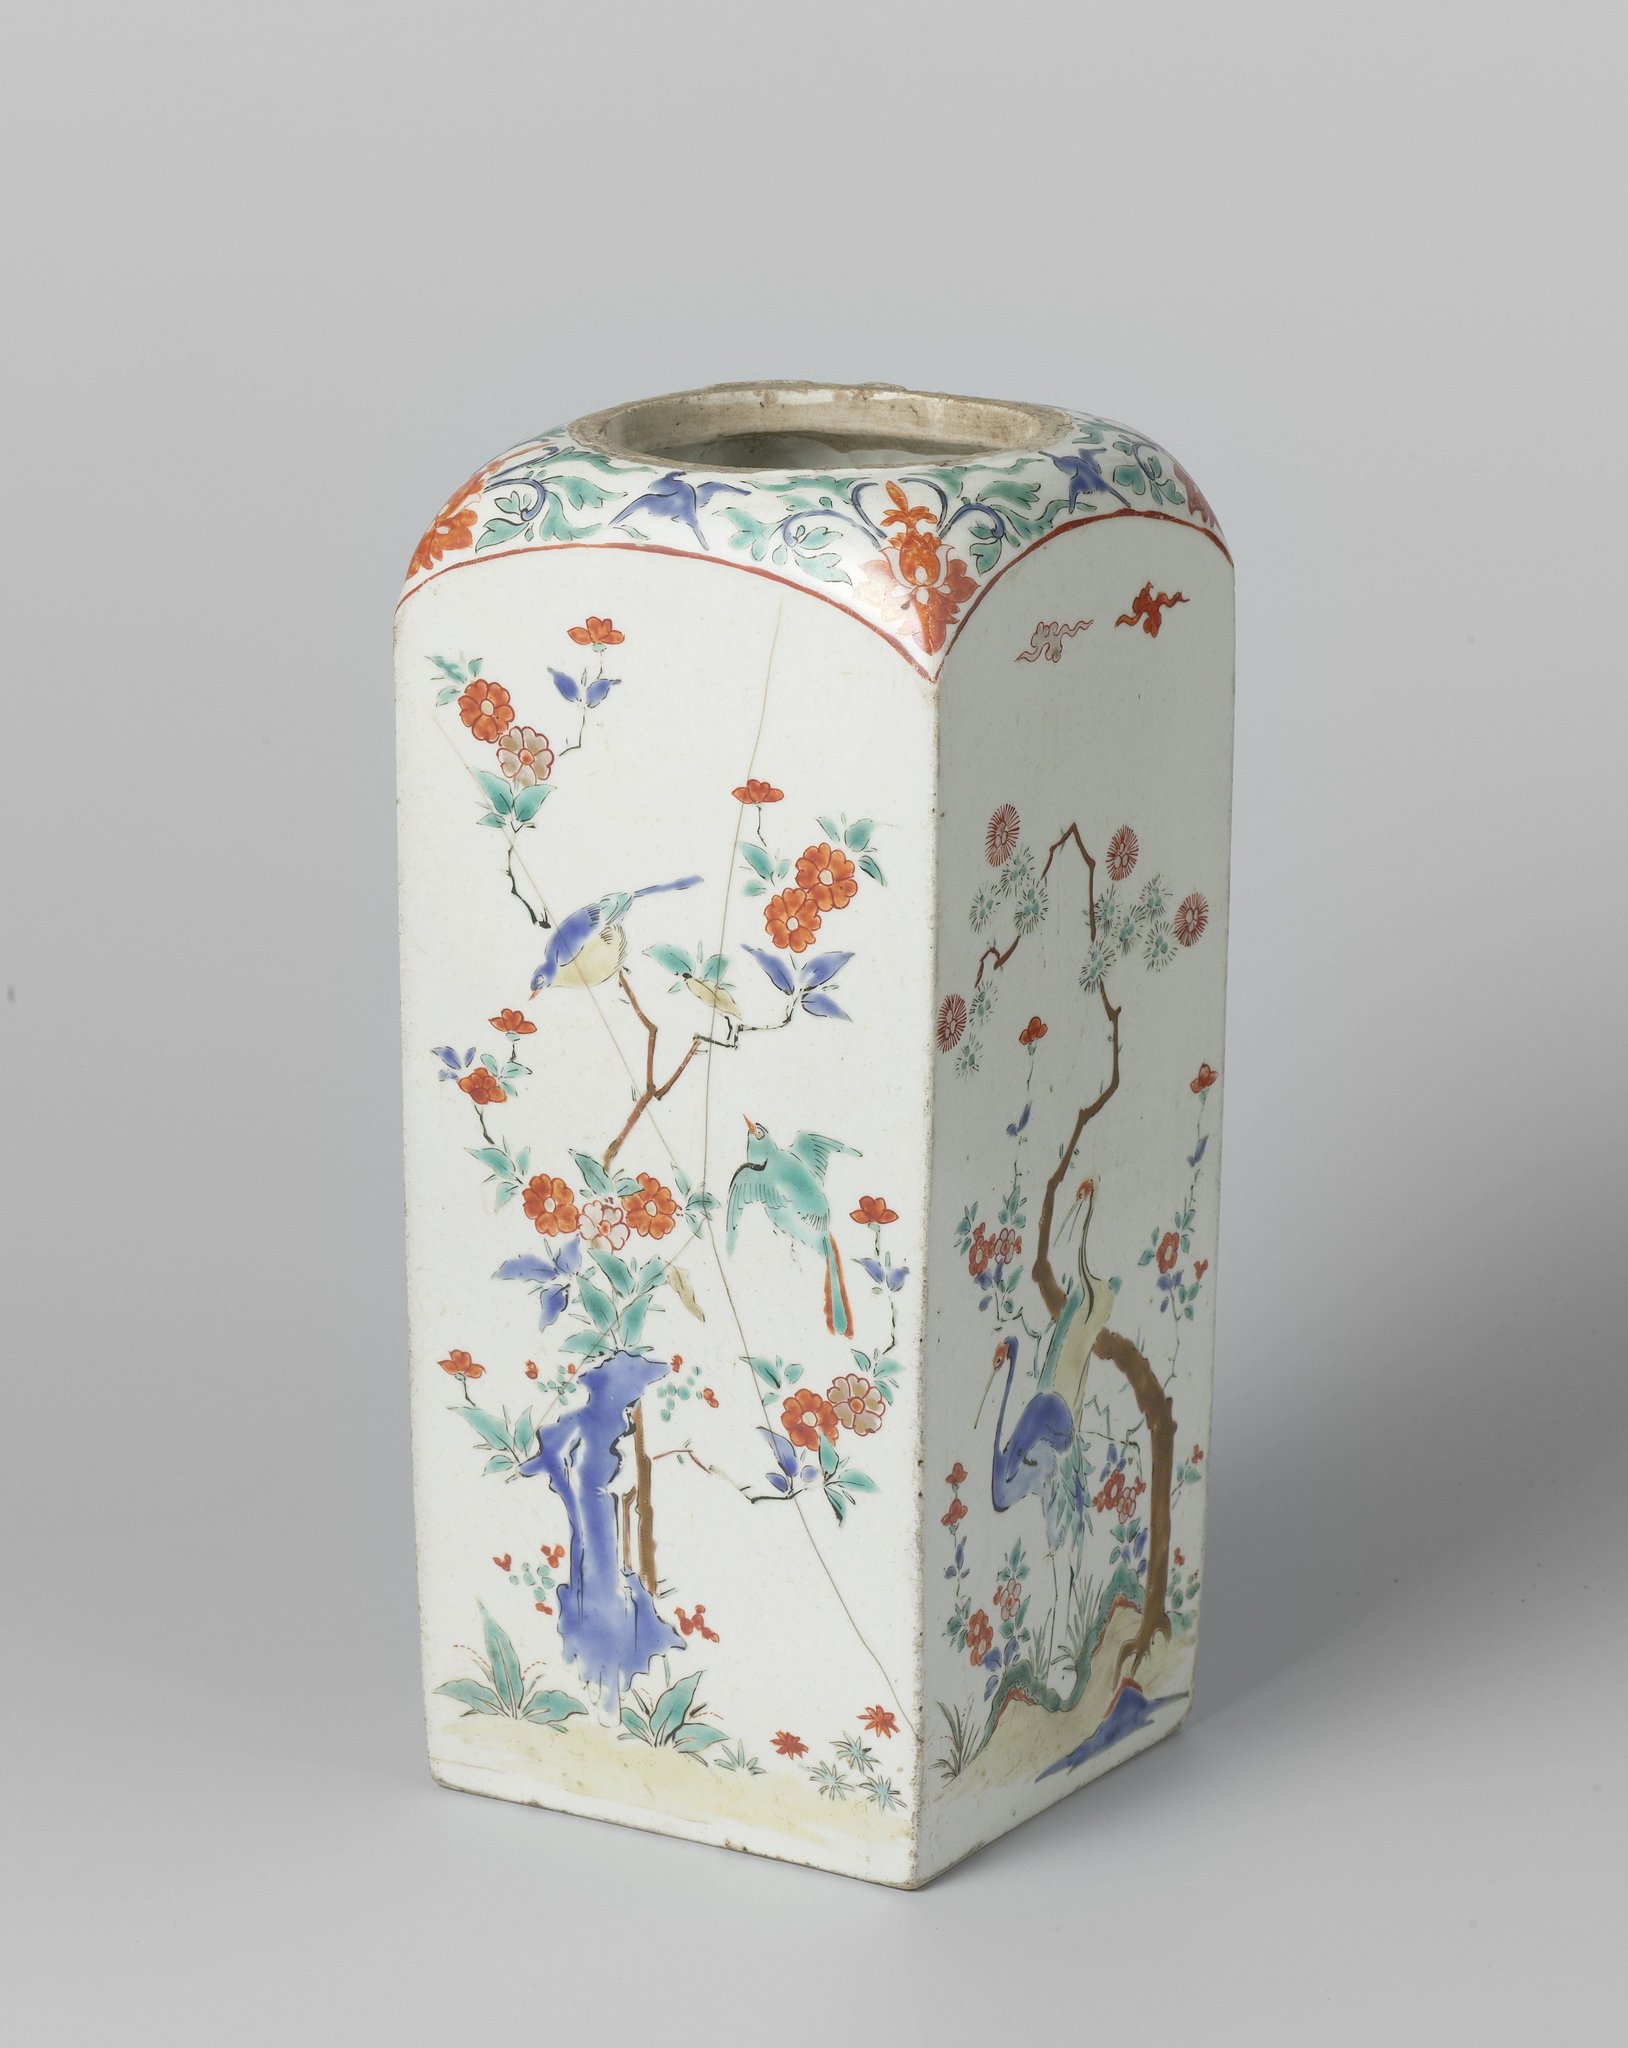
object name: bottle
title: Square bottle with the 'three friends', birds and floral scrolls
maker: Anonymous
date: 1670-1690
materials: glaze, gold, paint, porcelain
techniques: firing, forming, gilding, vitrification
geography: japan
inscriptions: inscription: ‘a’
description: Fles van porselein, vierkant met afgeronde schouder, ronde lage hals en rond deksel met knop. Beschilderd in blauw, rood, groen, geel, bruin, zwart en goud met op de wanden respectievelijk twee ooievaars op rotsachtige bodem bij pijnboom en prunus, twee vogels op de tak van een prunus bij rotsen, twee vogels op bamboe bij rotsen en twee vogels op een prunusachtige bij rots. op de schouder symmetrische bloemranken en vogels. op de hals ornamenten en op het deksel hetzelfde decor als op de schouder. Rozet in rood en goud op de knop. Tussen schouder en wanden een gebogen rode bies. Kakiemon decor.